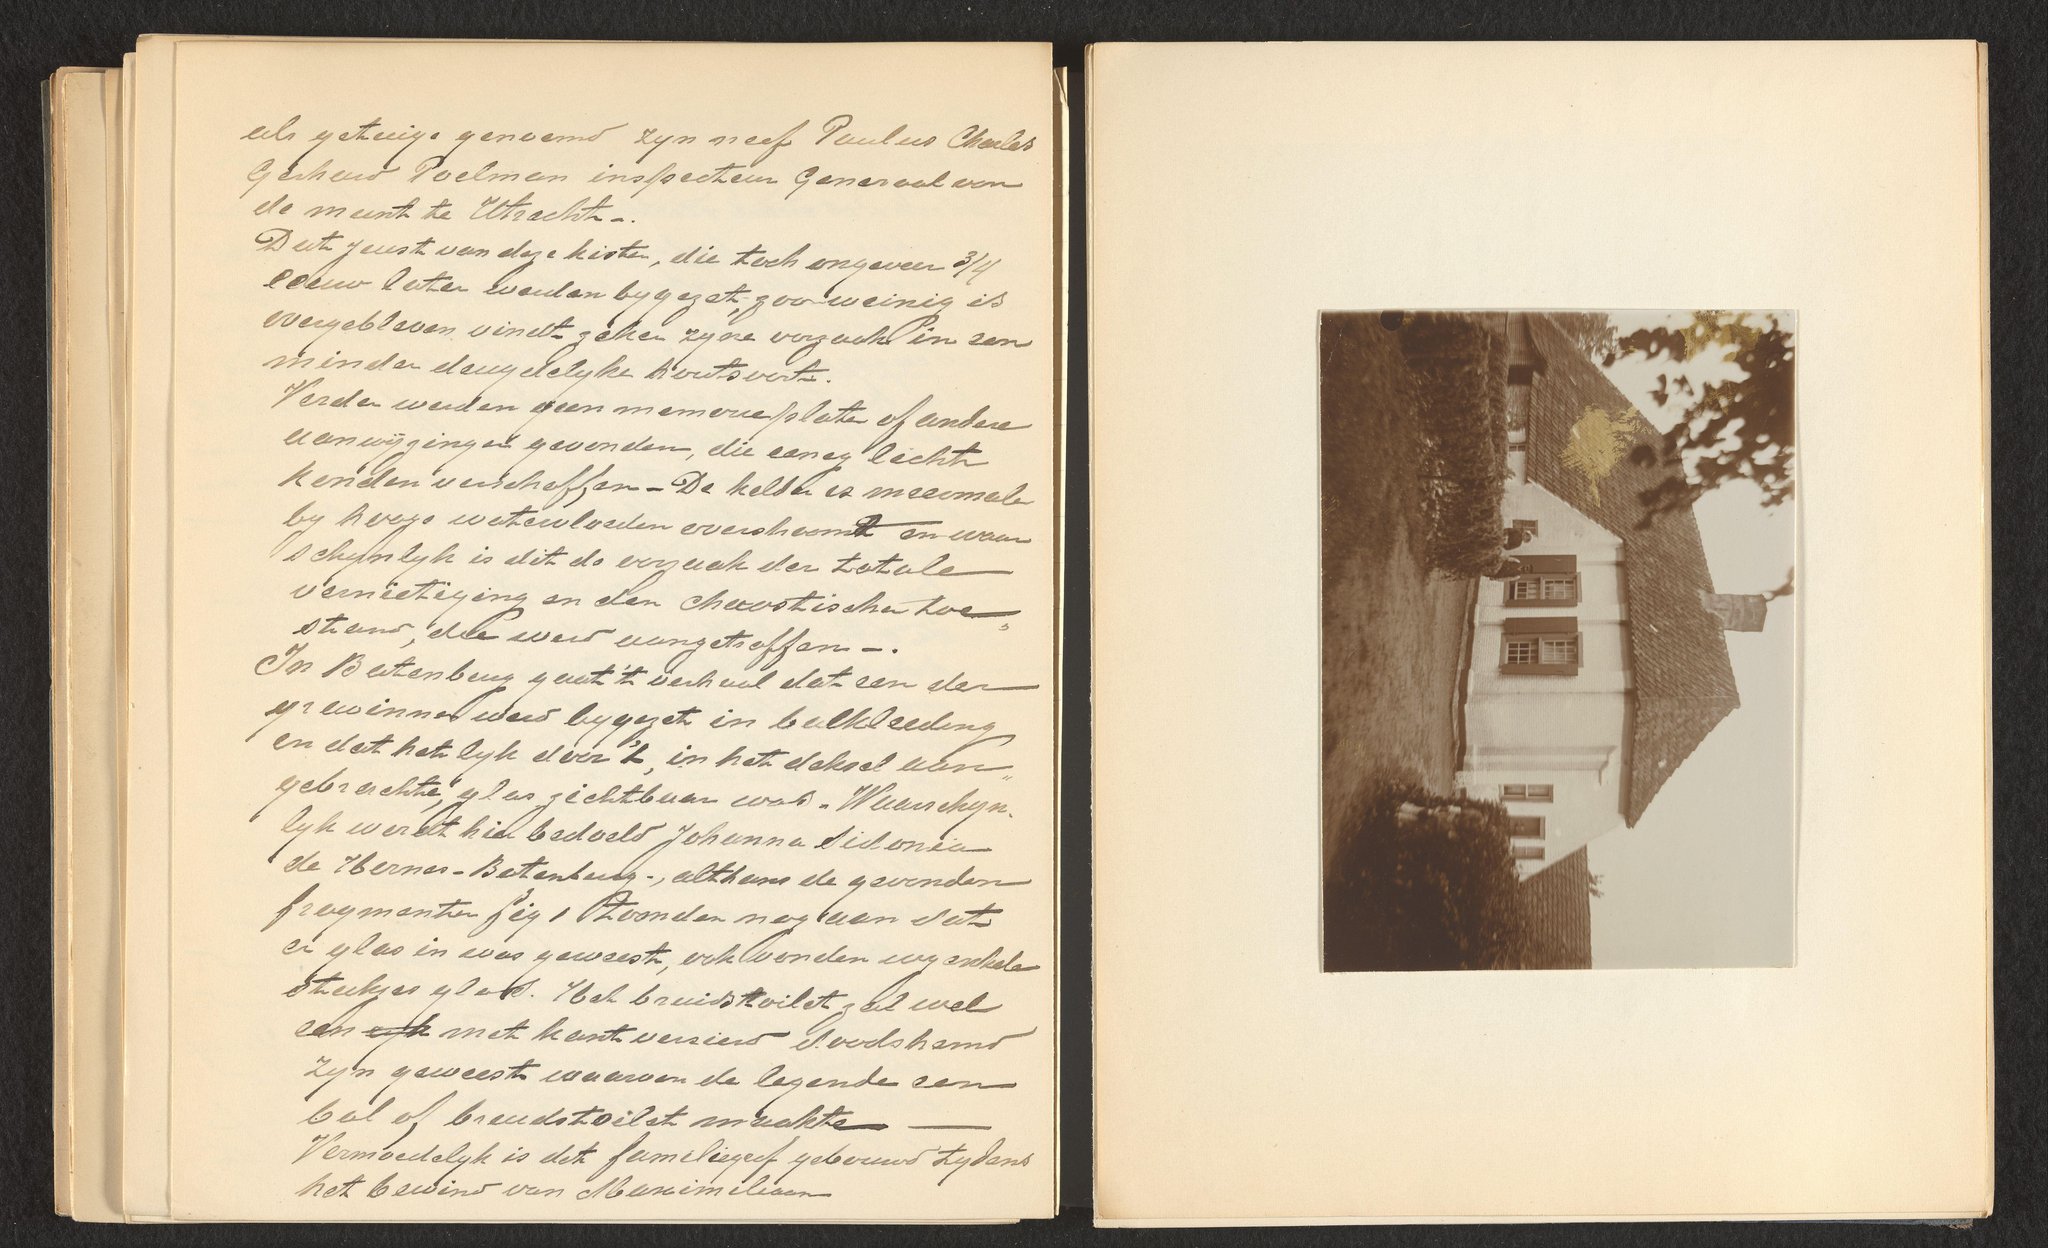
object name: page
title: Woning tegenover kasteel Batenburg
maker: benjamin charlé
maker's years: 1845-1925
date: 1903-1908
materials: paper, cardboard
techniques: collodion silver print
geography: batenburg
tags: rural housing, e.g. country-house, villa, cottage